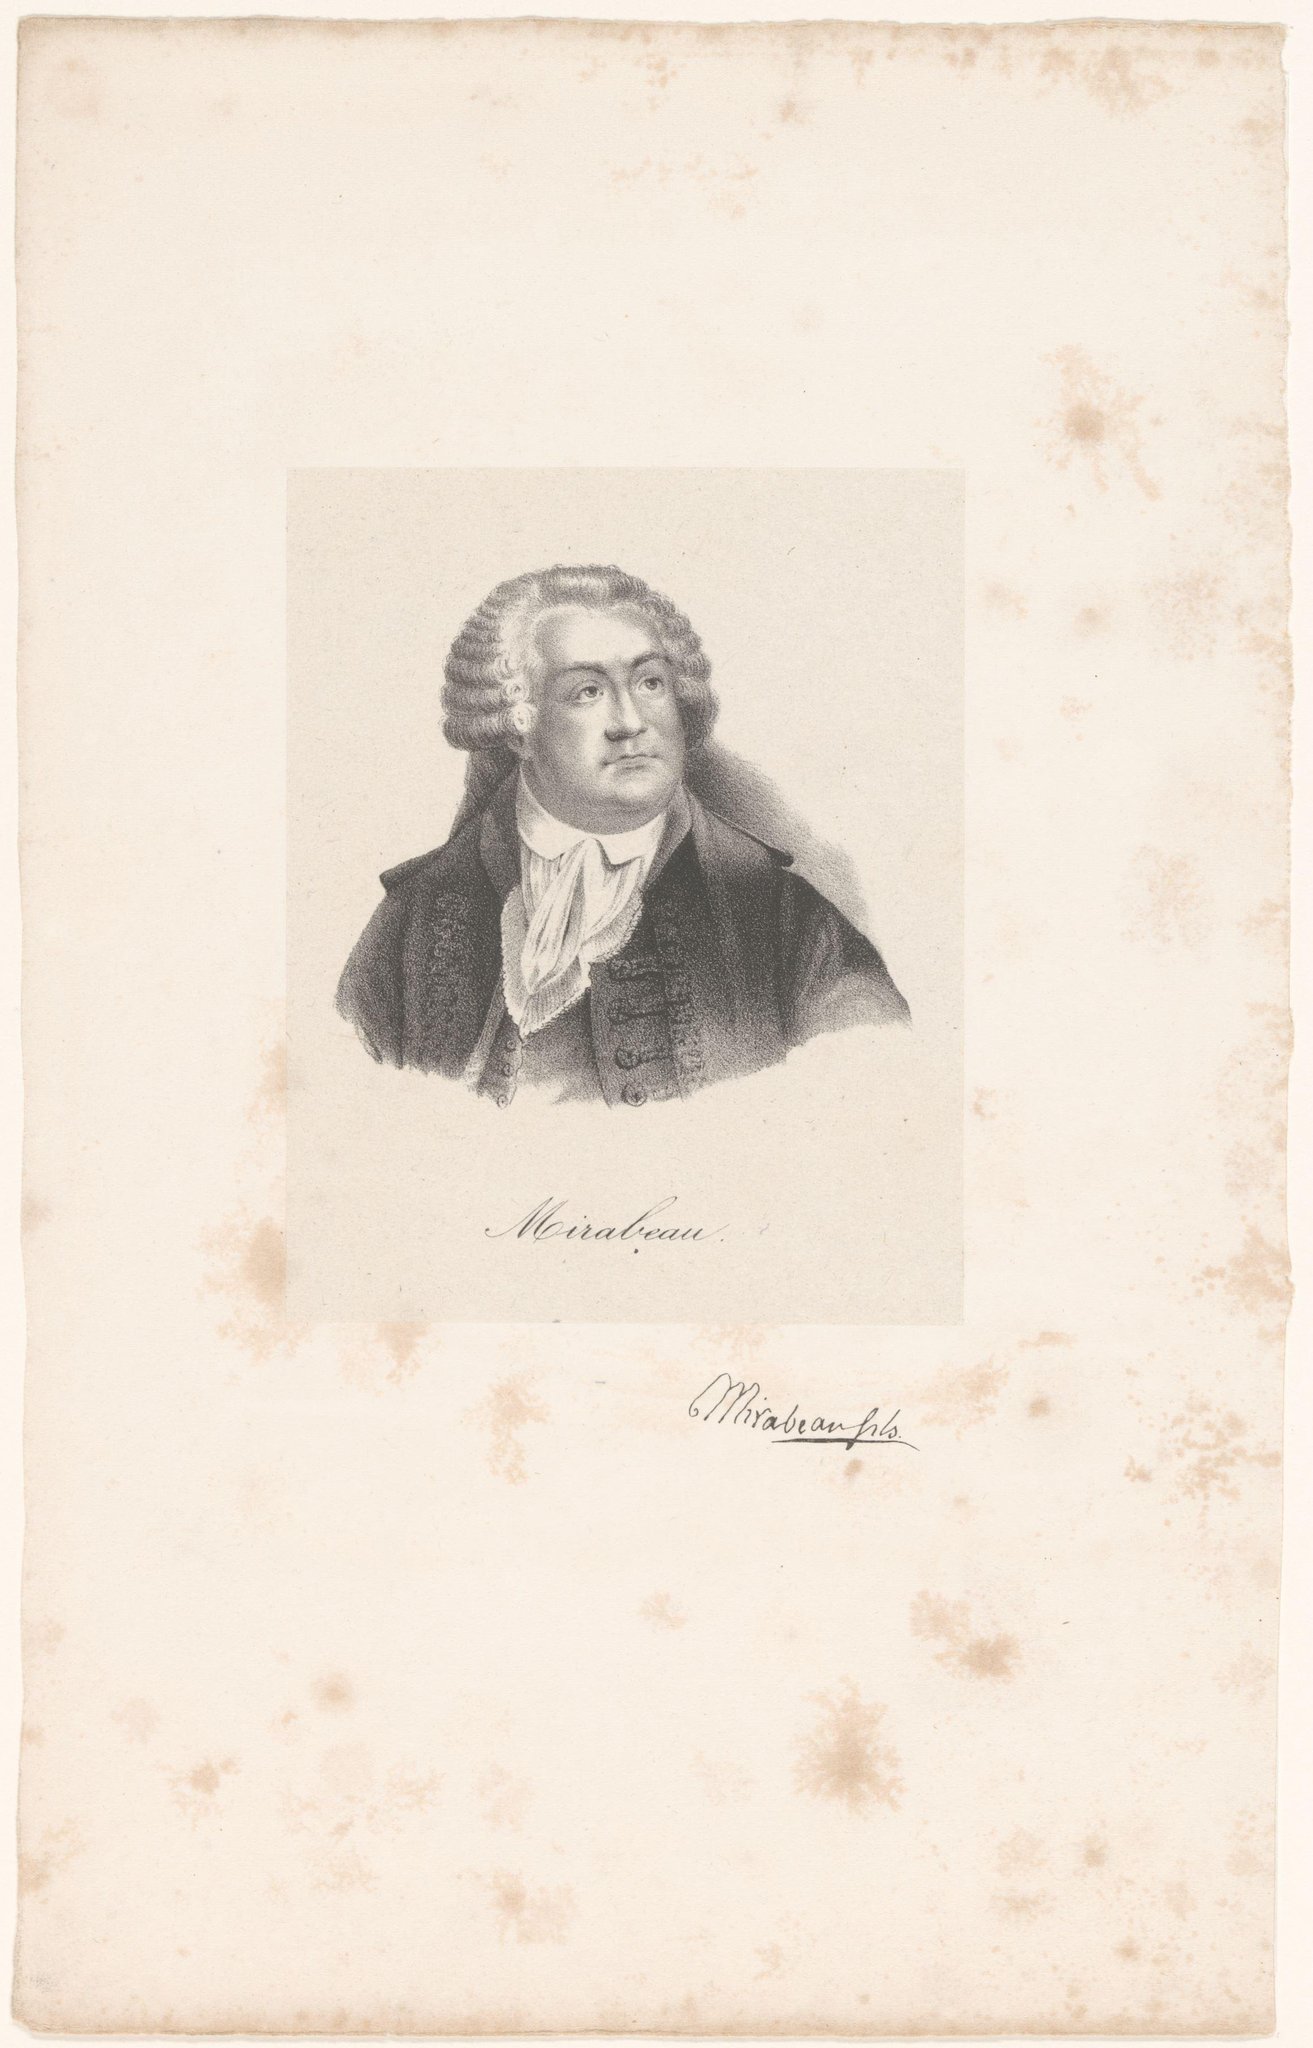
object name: print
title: Mirabeau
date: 1818-1842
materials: paper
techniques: lithograph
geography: paris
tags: paris, honoré-gabriel de riqueti (graaf van mirabeau), historical persons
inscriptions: collector's mark: Lugt 2228a